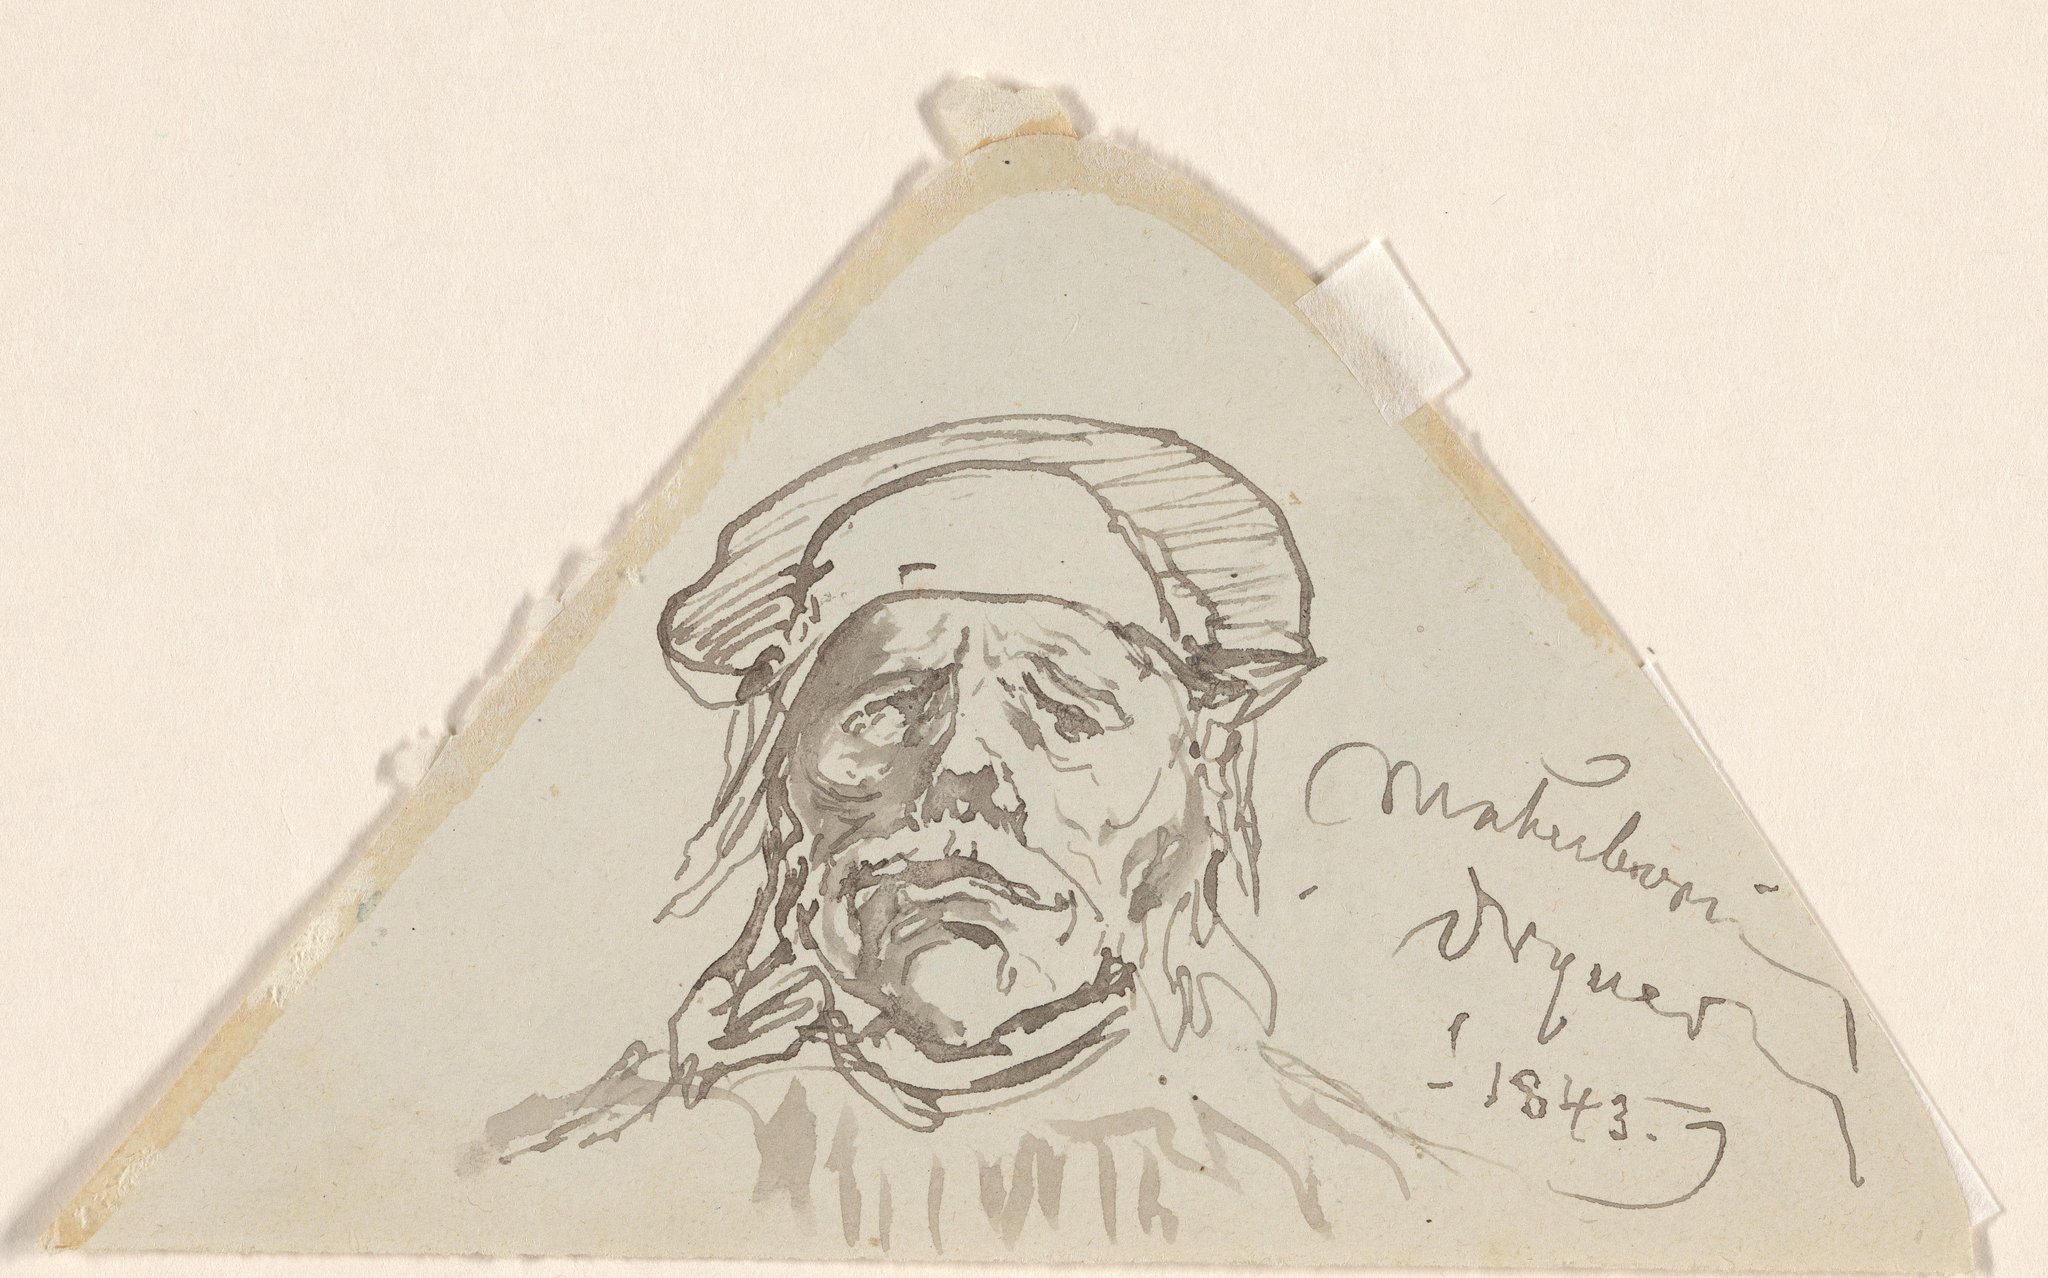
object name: drawing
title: Materborn drijver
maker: johannes tavenraat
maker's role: draughtsman, painter, print maker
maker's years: 1809-1881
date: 1843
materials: ink, paper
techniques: pen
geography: materborn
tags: beaters (~ hunt)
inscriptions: date and inscription: ‘Materborn drijver - 1843’, collector's mark: Lugt 2228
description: Kop van een drijver. Getekend op een fragment van een envelop.